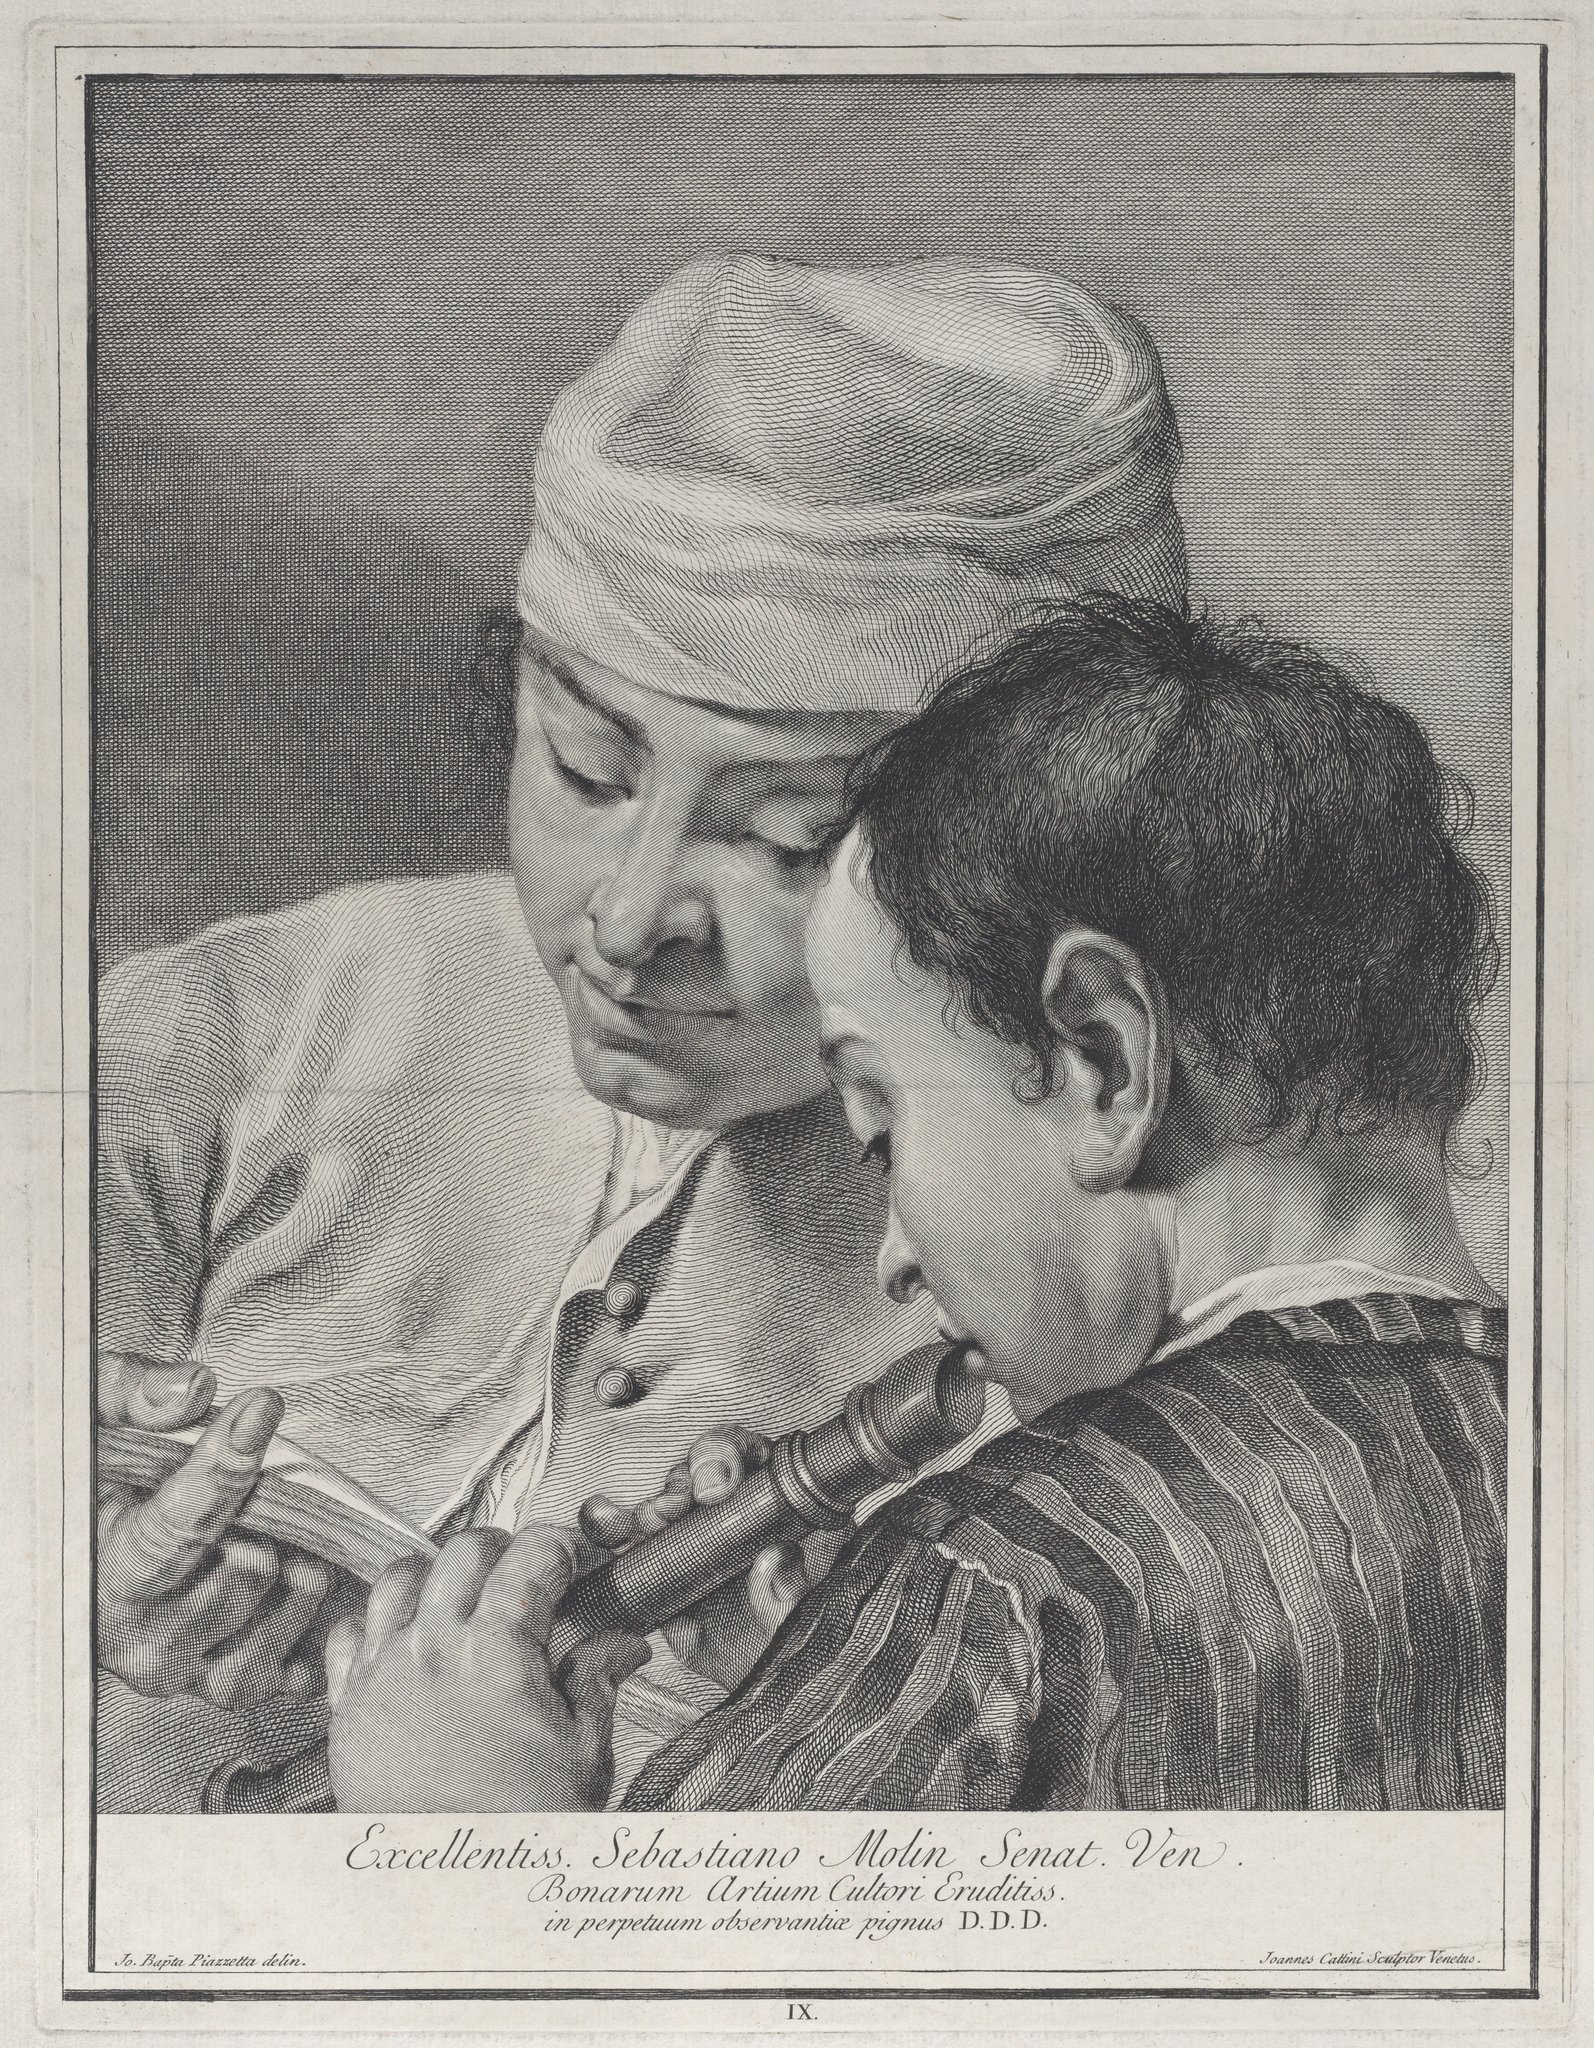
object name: print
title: Plate 9: A youth playing the recorder while a man to the left holds up a music book; from 'Icones ad vivum expressae' after Giovanni Battista Piazzetta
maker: giovanni cattini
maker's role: artist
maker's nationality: italian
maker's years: 1715-1800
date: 1743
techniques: etching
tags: musical instruments,men,musicians